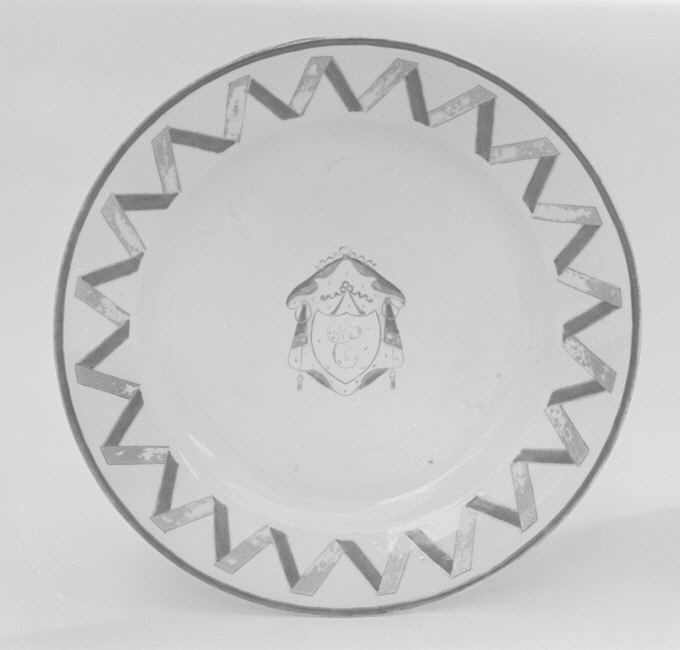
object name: plate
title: Plate (part of a set)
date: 1790-1800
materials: hard paste porcelain